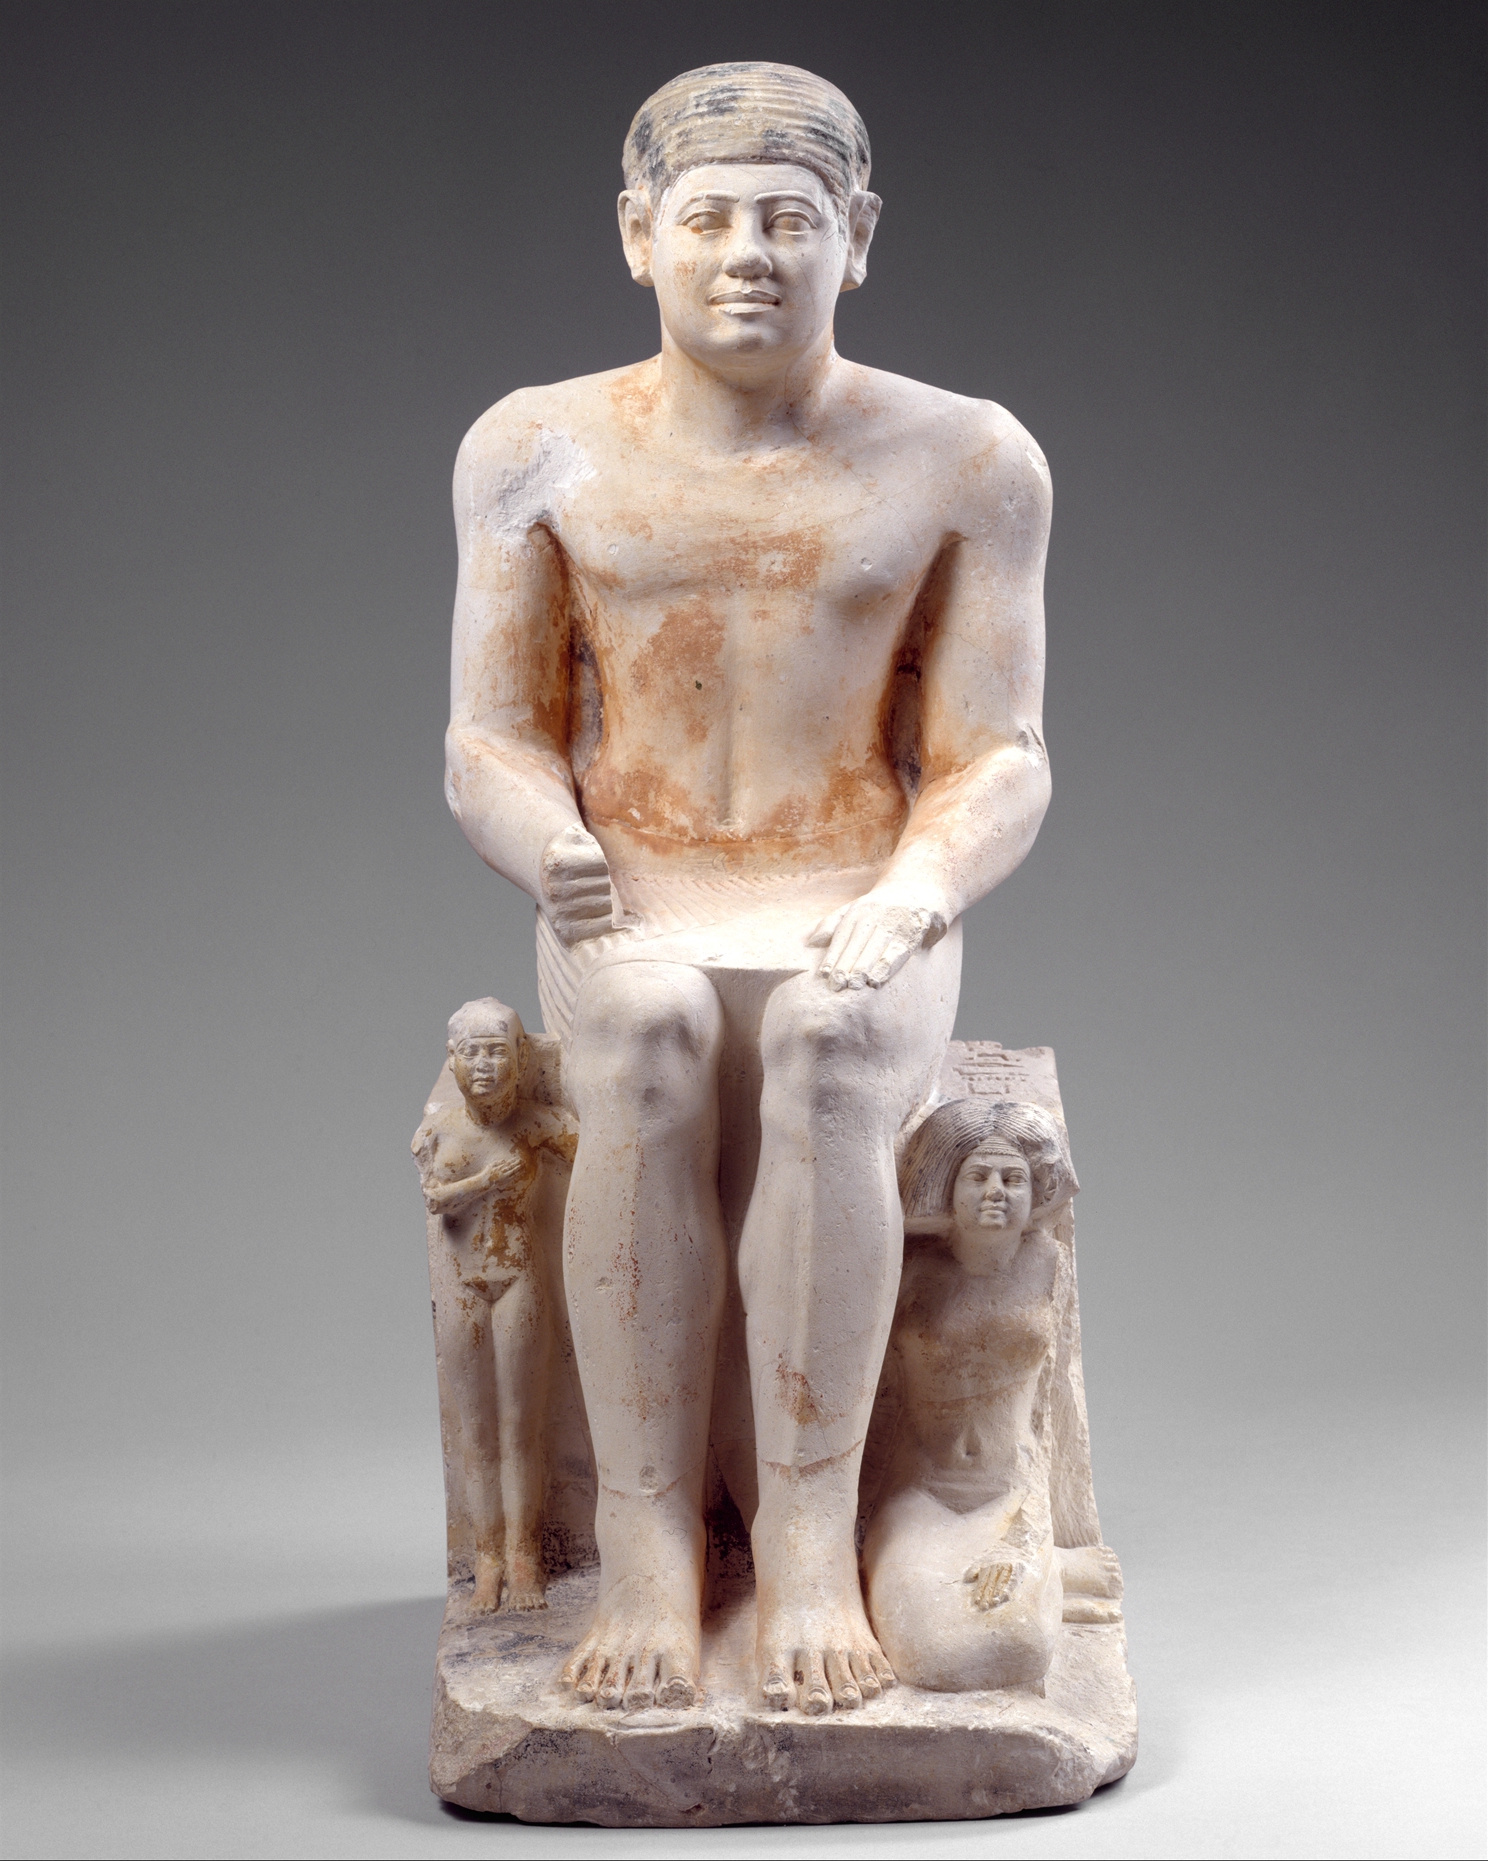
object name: statue group, nikare, wife, daughter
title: Nikare with his Wife and Daughter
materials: limestone, paint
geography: memphite region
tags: men,women